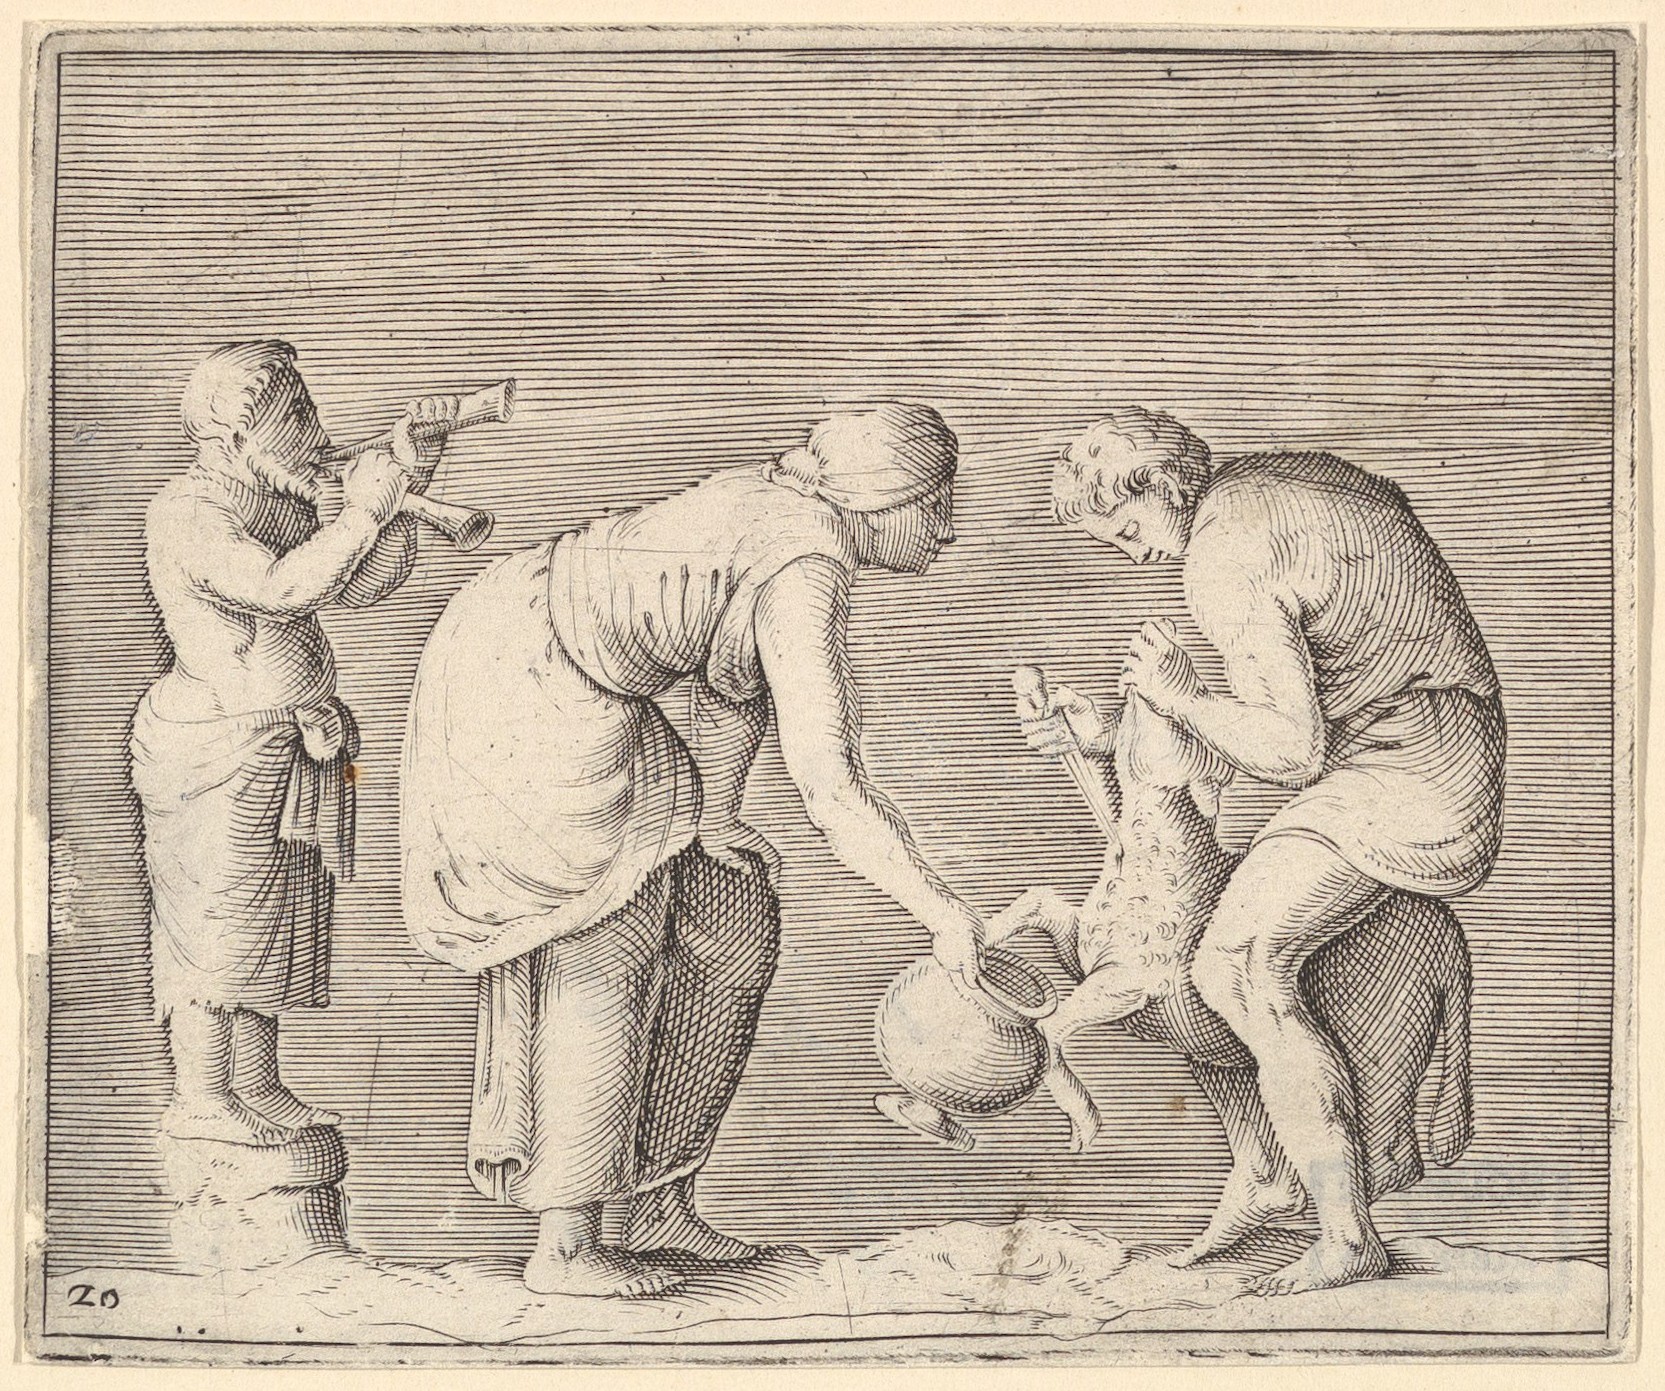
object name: print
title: A Woman Collecting Blood from a Sheep, from "Ex Antiquis Cameorum et Gemmae Delineata/ Liber Secundus/et ab Enea Vico Parmen Incis"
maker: anonymous, italian, 16th century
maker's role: artist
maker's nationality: italian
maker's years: 1500-1600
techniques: engraving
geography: rome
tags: musical instruments,weapons,men,women,sheep